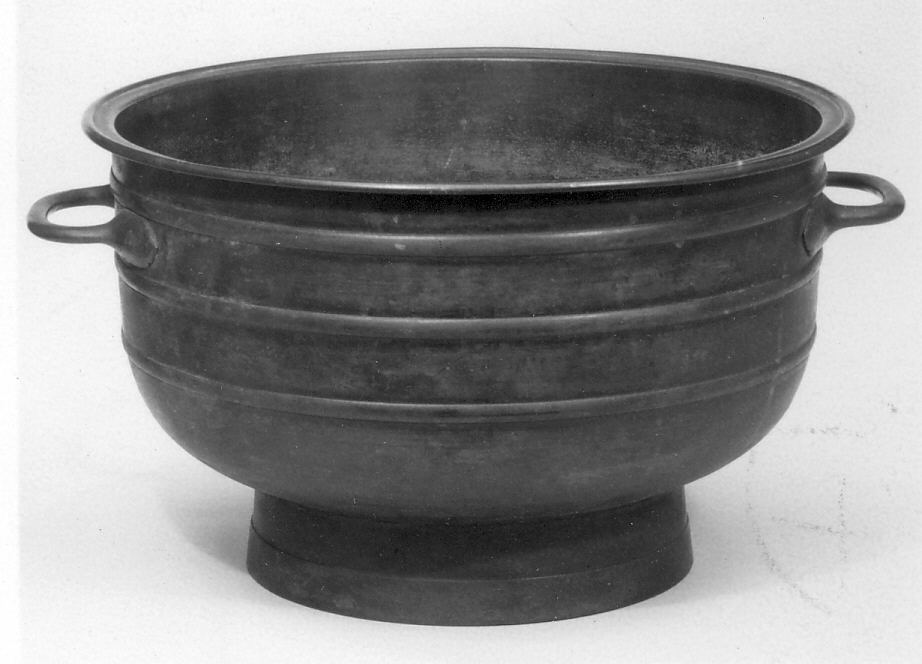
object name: vessel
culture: japanese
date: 1801-1900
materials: bronze